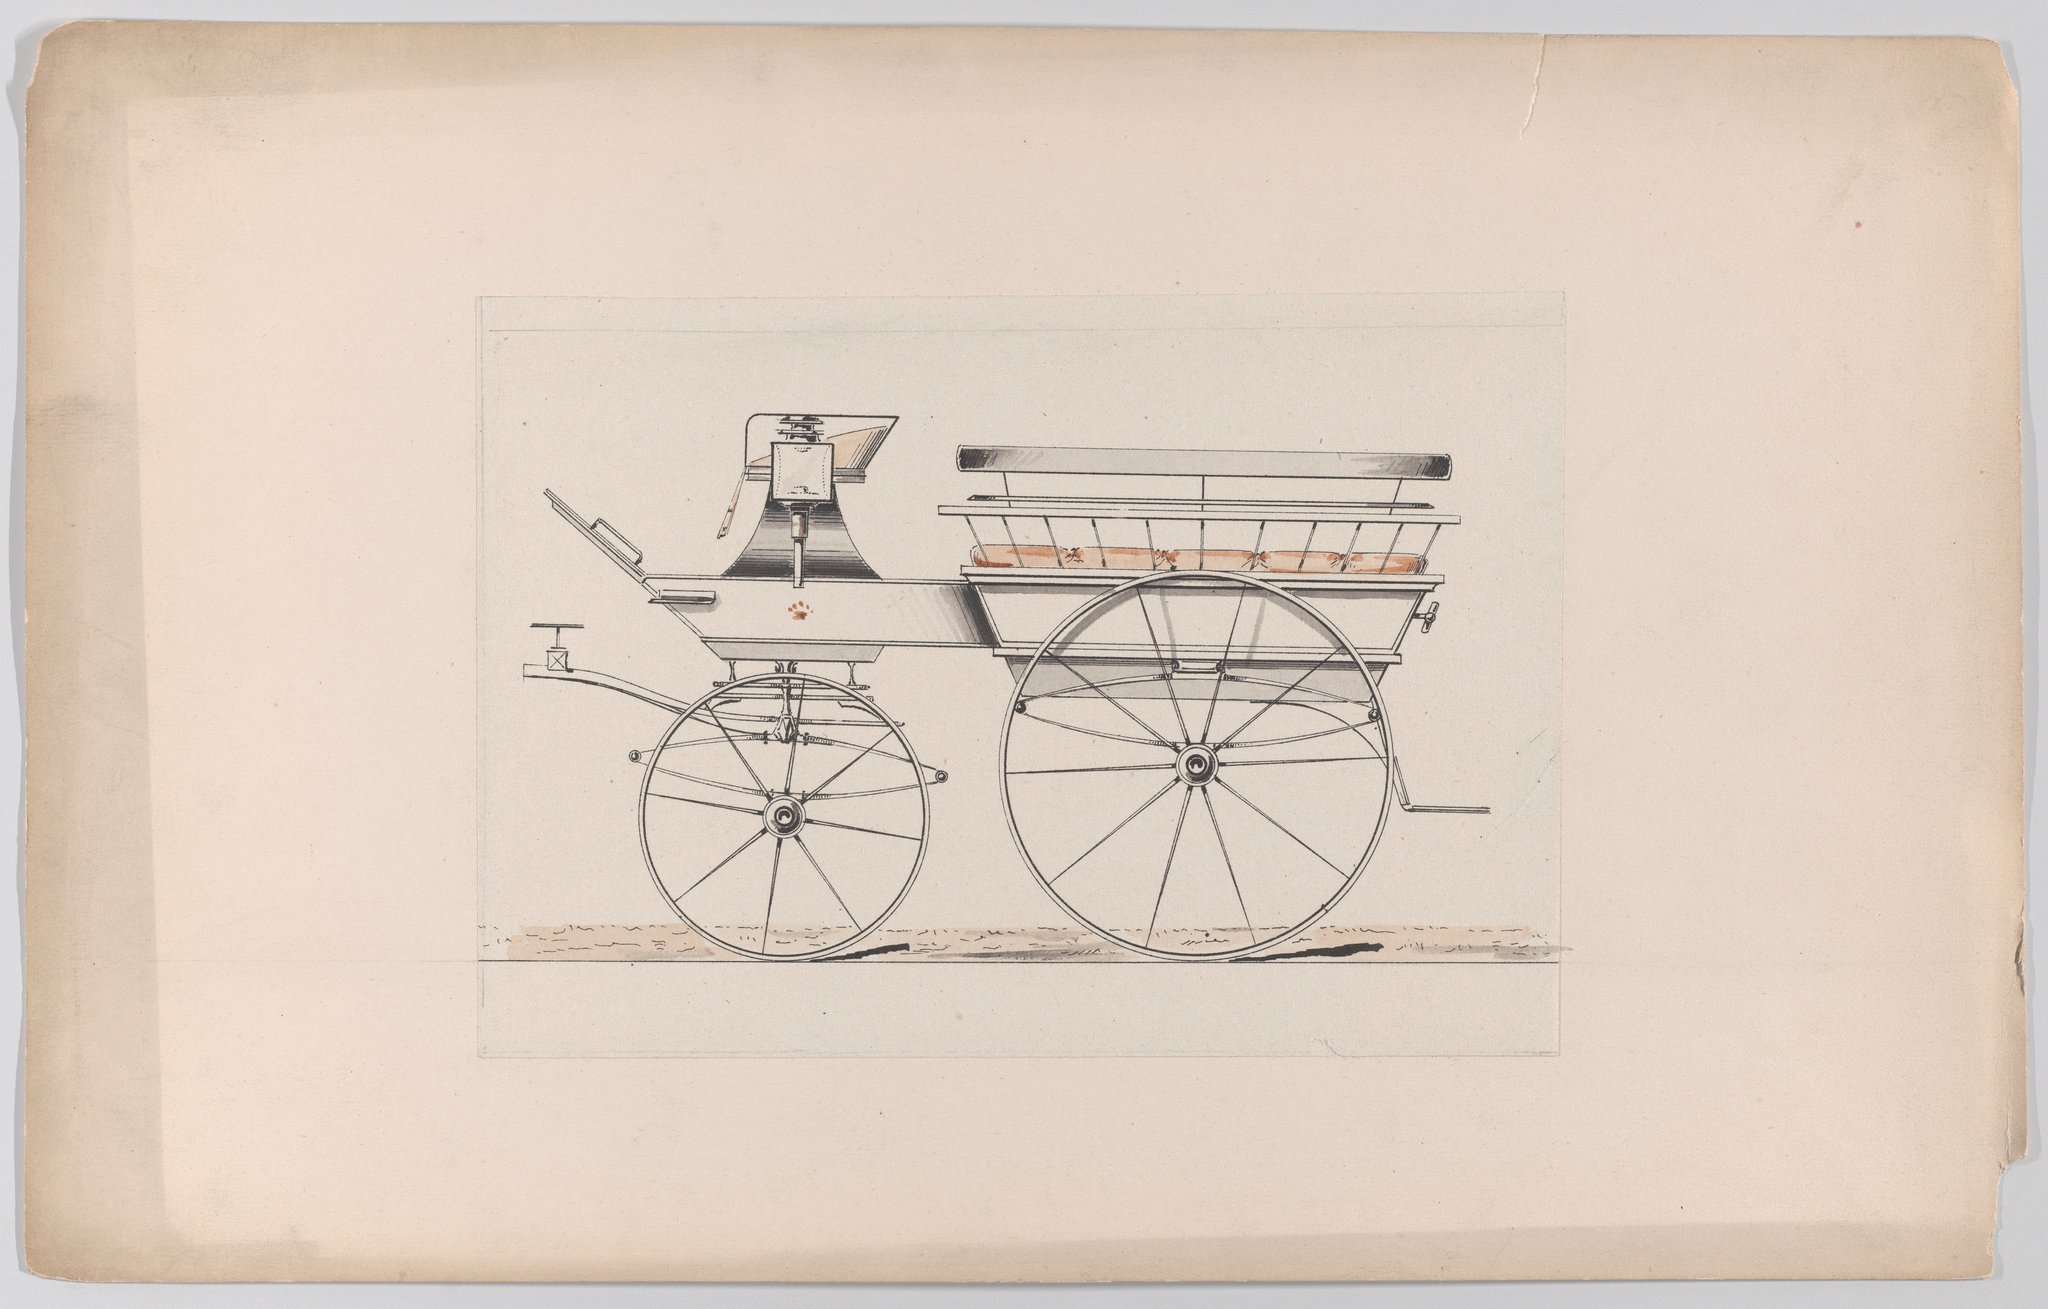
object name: drawing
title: Design for Wagonette (unnumbered)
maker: brewster & co.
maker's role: manufacturer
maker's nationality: american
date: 1880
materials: gouache, ink, watercolor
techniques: pen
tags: carriages